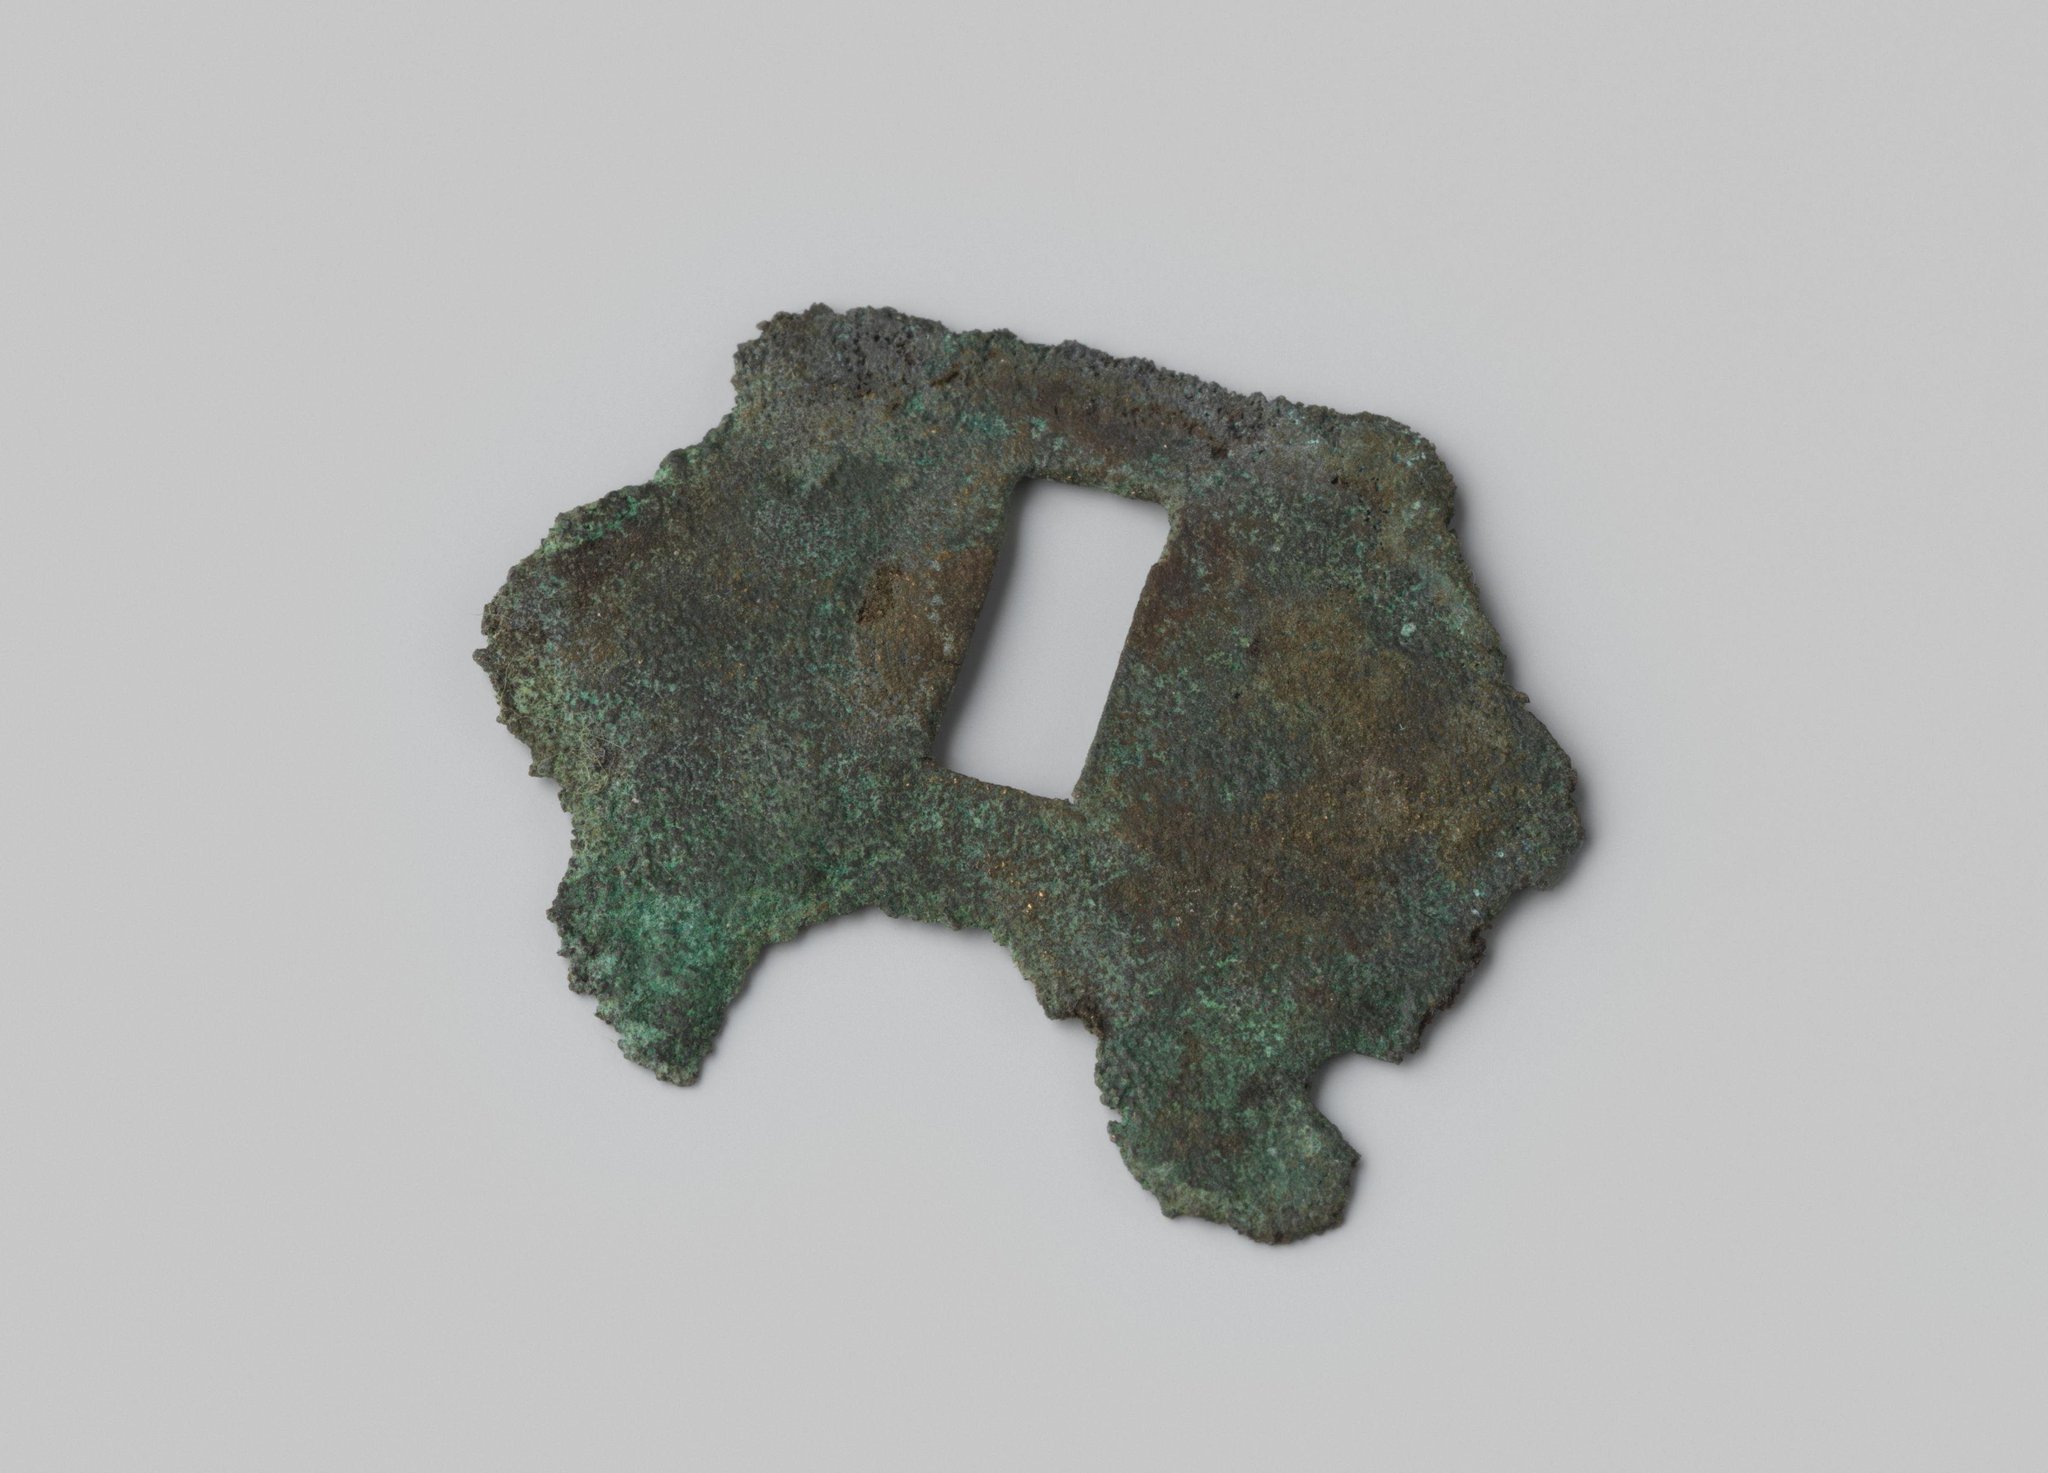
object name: lock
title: Deel van een slot uit het wrak van de Oost-Indiëvaarder Hollandia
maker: Anonymous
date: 1700-1743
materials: copper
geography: netherlands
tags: verenigde oostindische compagnie, hollandia (schip), annet